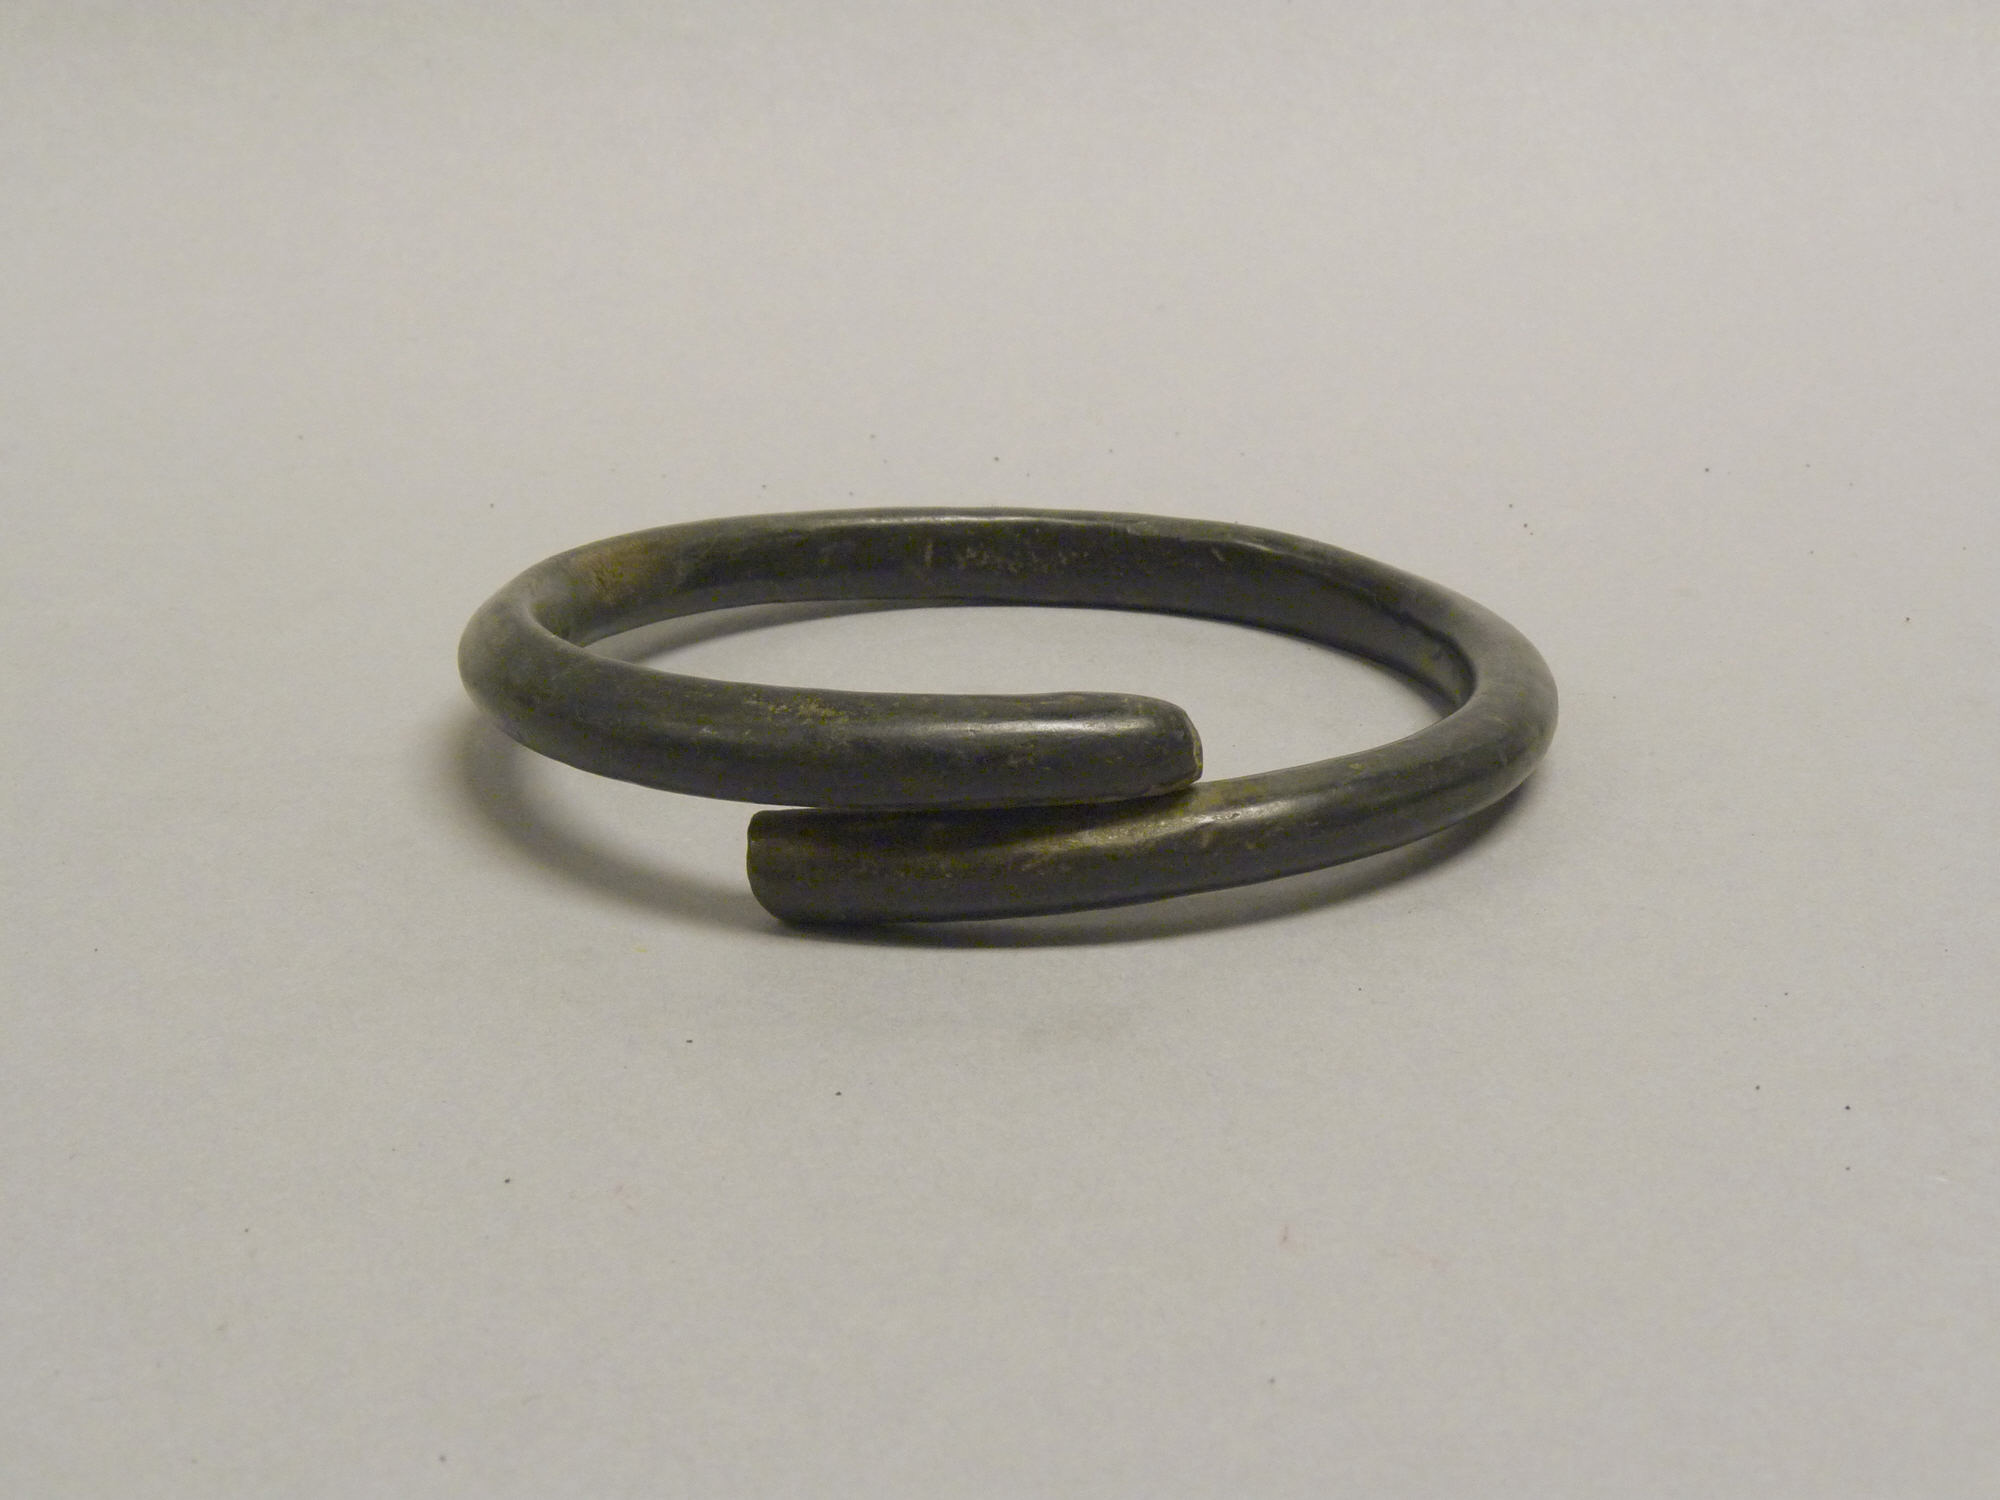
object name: anklet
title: One of a Pair of Overlapping Undecorated Anklets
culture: vietnamese, north, highlands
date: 500 BCE-300 CE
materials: bronze